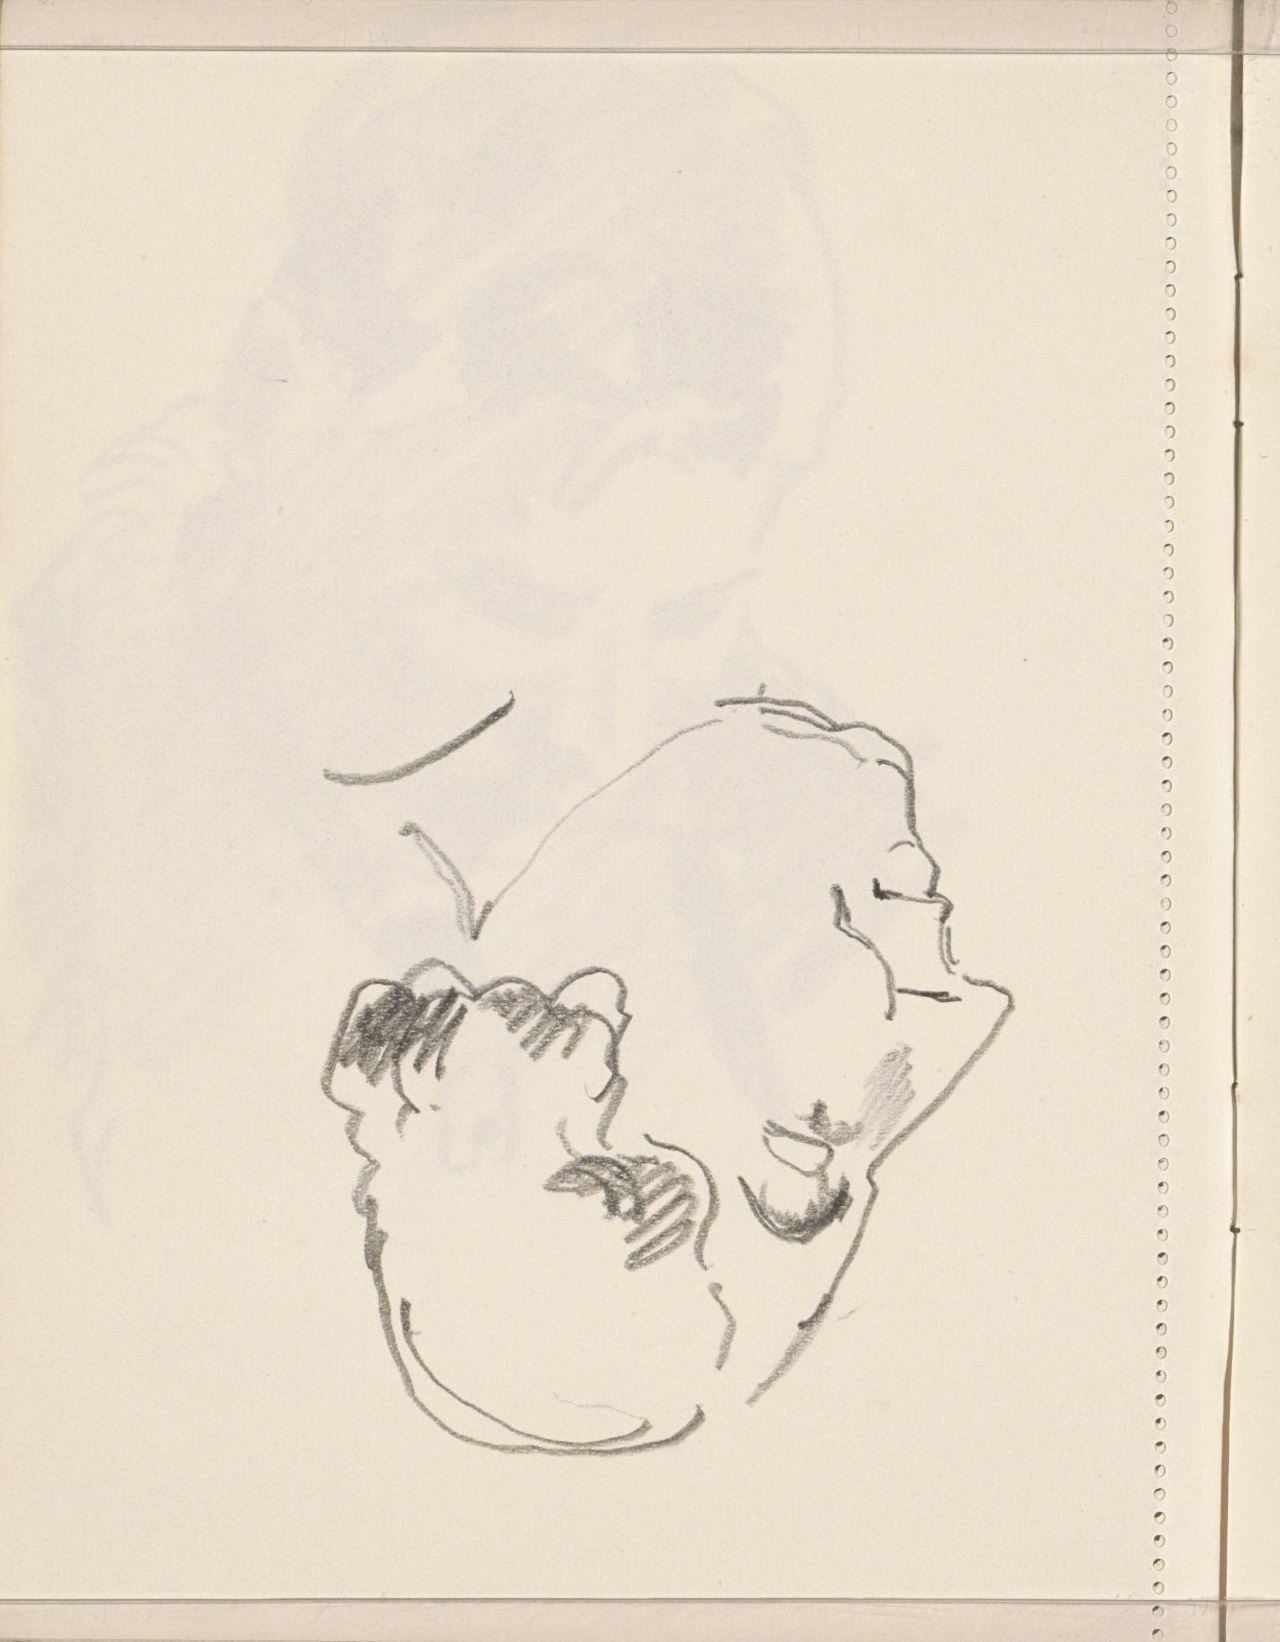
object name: sketchbook leaf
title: Kop van een man met krullend haar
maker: cornelis vreedenburgh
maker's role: draughtsman, print maker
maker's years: 1880-1946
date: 1890-1946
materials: paper, pencil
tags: head (human) (+ left side visible; left - (l. hand, l. foot, etc.))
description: Blad 59 verso uit een schetsboek met 71 bladen.